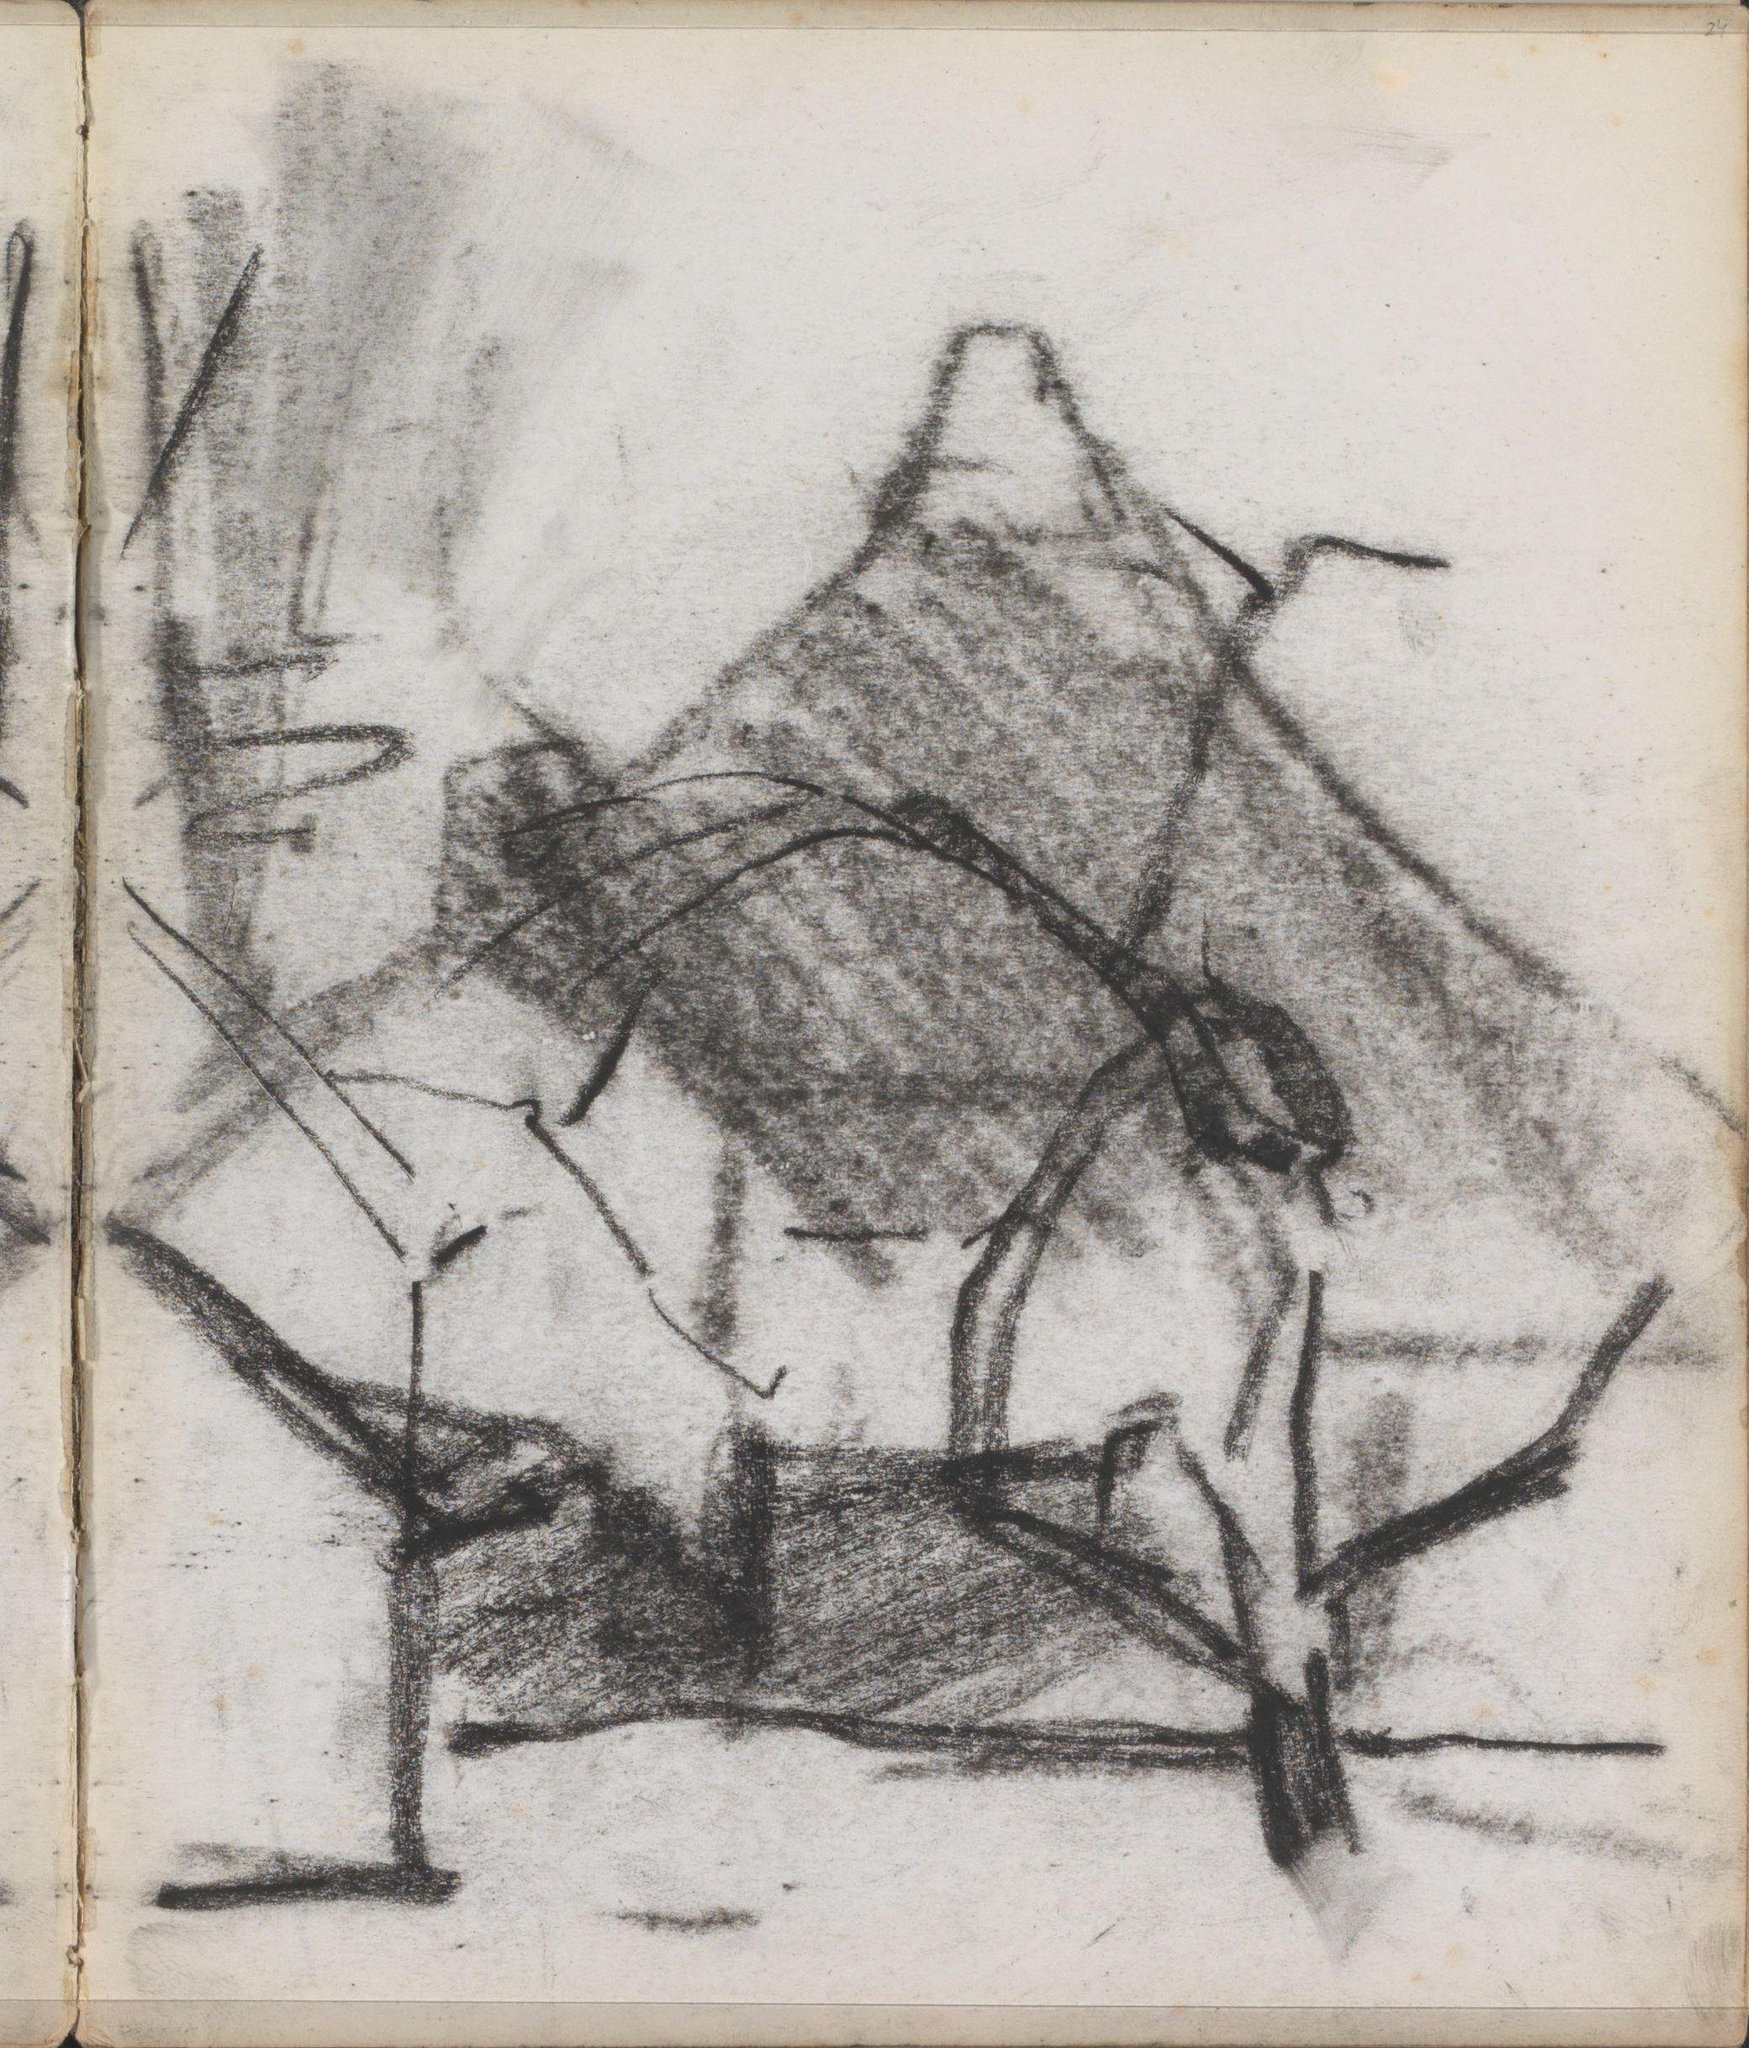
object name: sketchbook leaf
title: Studie, mogelijk van een paard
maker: george hendrik breitner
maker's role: draughtsman, painter, print maker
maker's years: 1857-1923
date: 1880-1906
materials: chalk, paper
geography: netherlands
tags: horse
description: Pagina 24 uit een schetsboek met 81 bladen.